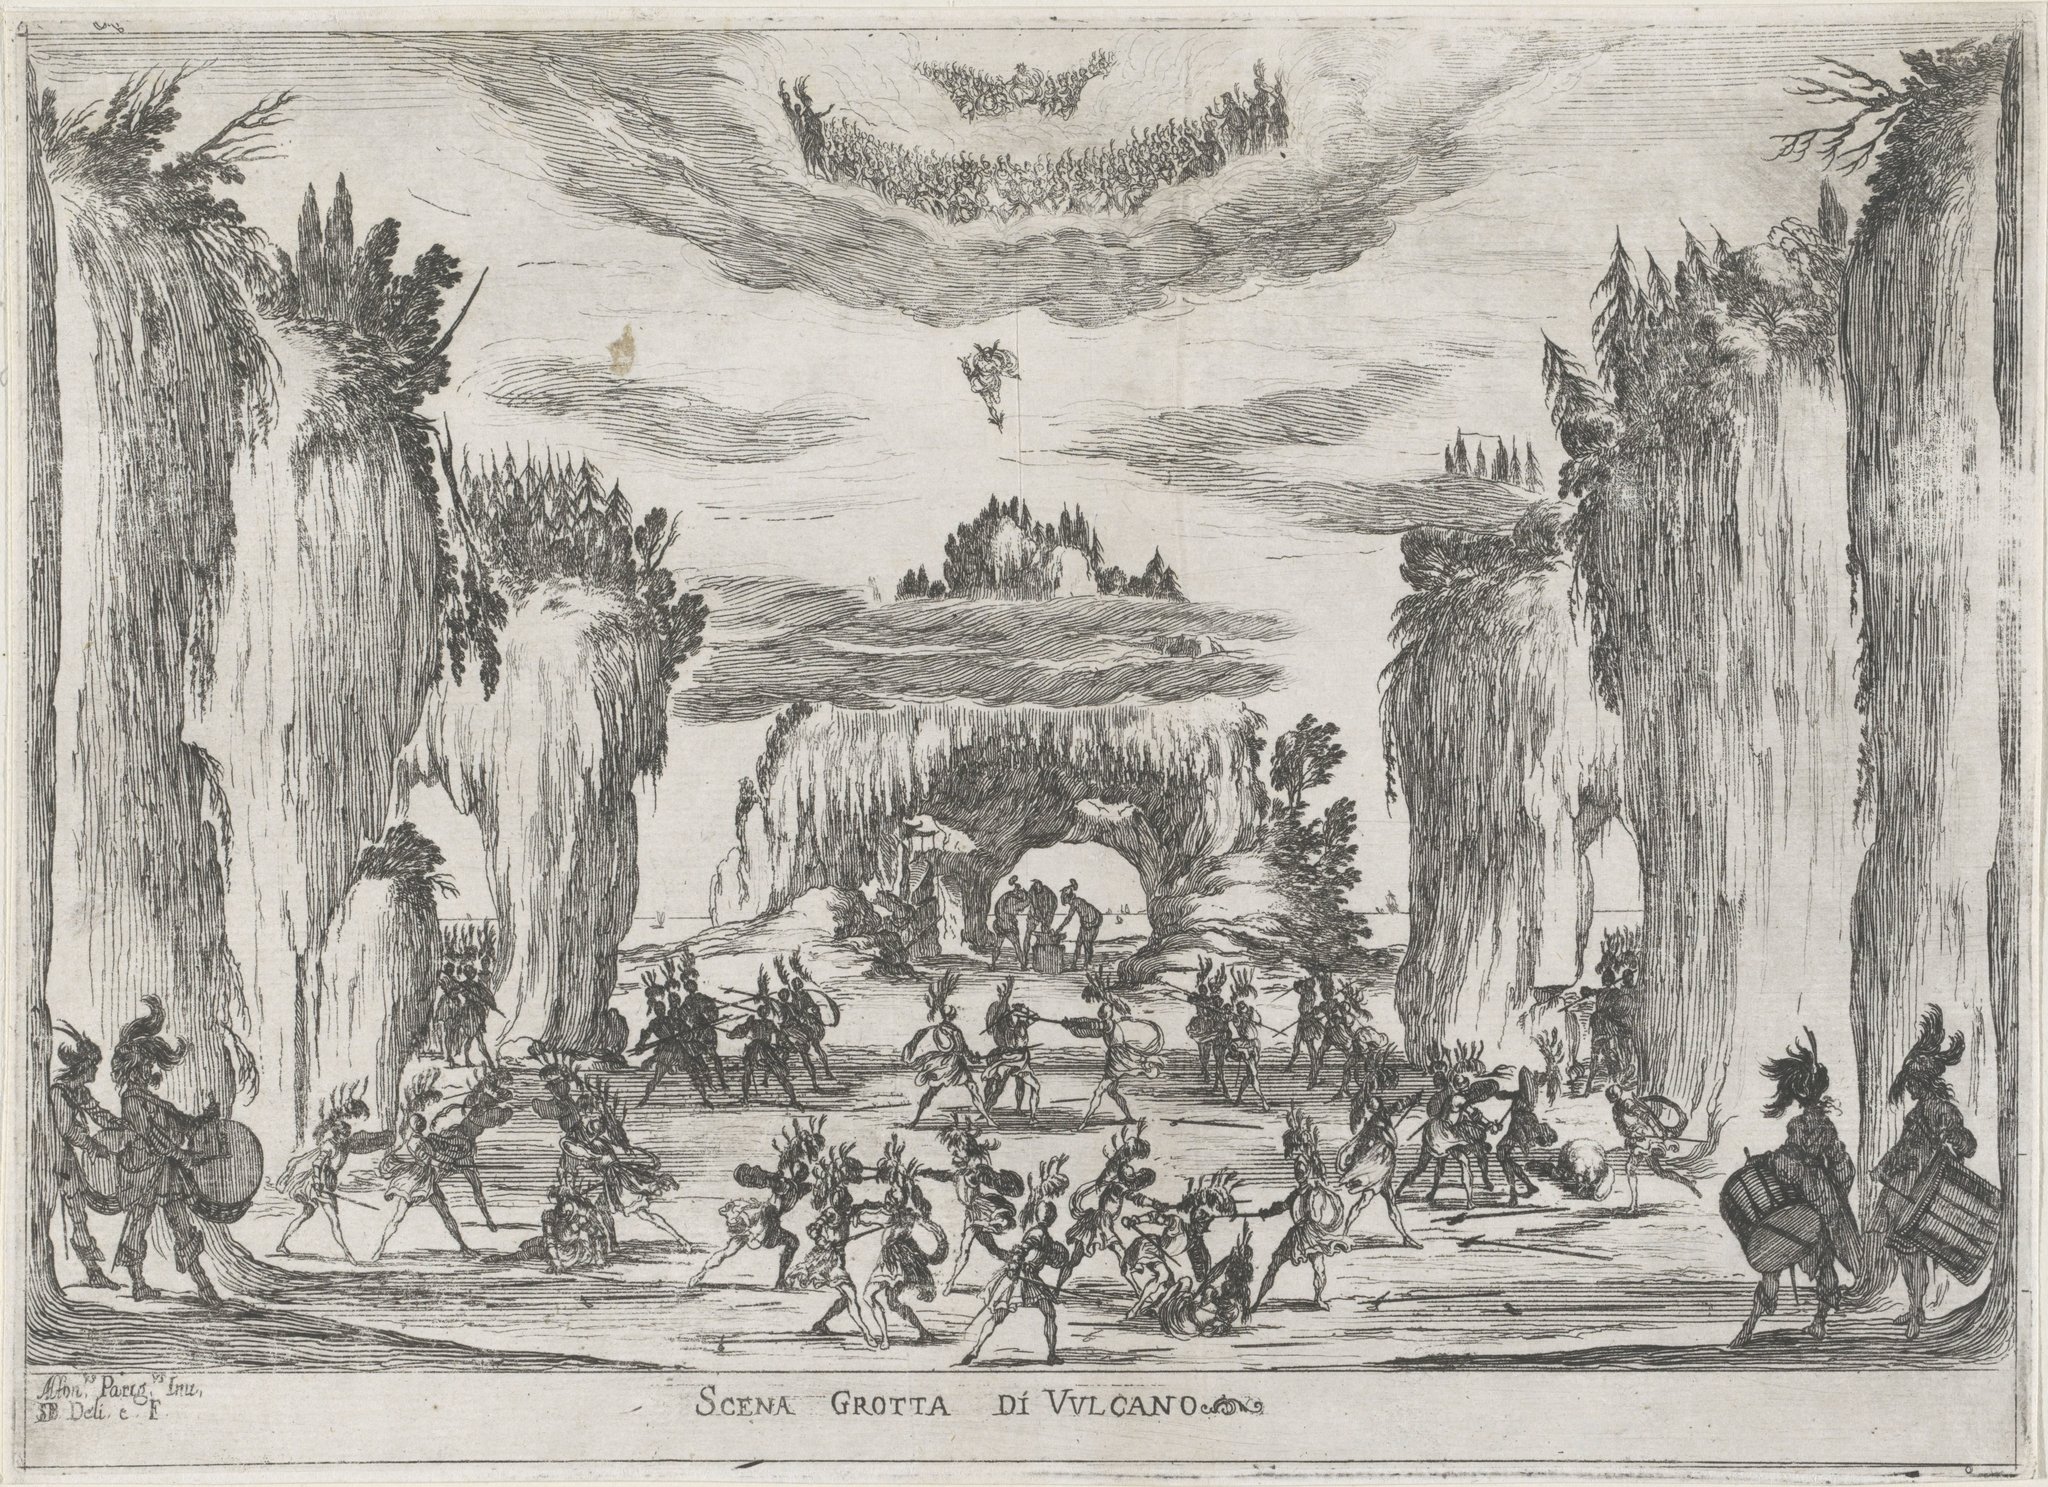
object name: ornament print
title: Scène: de grot van Vulcanus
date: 1637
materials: paper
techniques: etching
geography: italy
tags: set, scenery ~ stage, stage costume, the ballet, ballet performance, backdrop, vulcan in his smithy, actor (on the stage)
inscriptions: collector's mark: Lugt 240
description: Deze prent maakt deel uit van een reeks prenten met scènes uit het liberetto 'Le Nozze degli Dei Favola...' door Giovanni Carlo Coppola, ter ere van het huwelijk van Ferdinando II de' Medici en Vittoria della Rovere op 8 juli 1637.